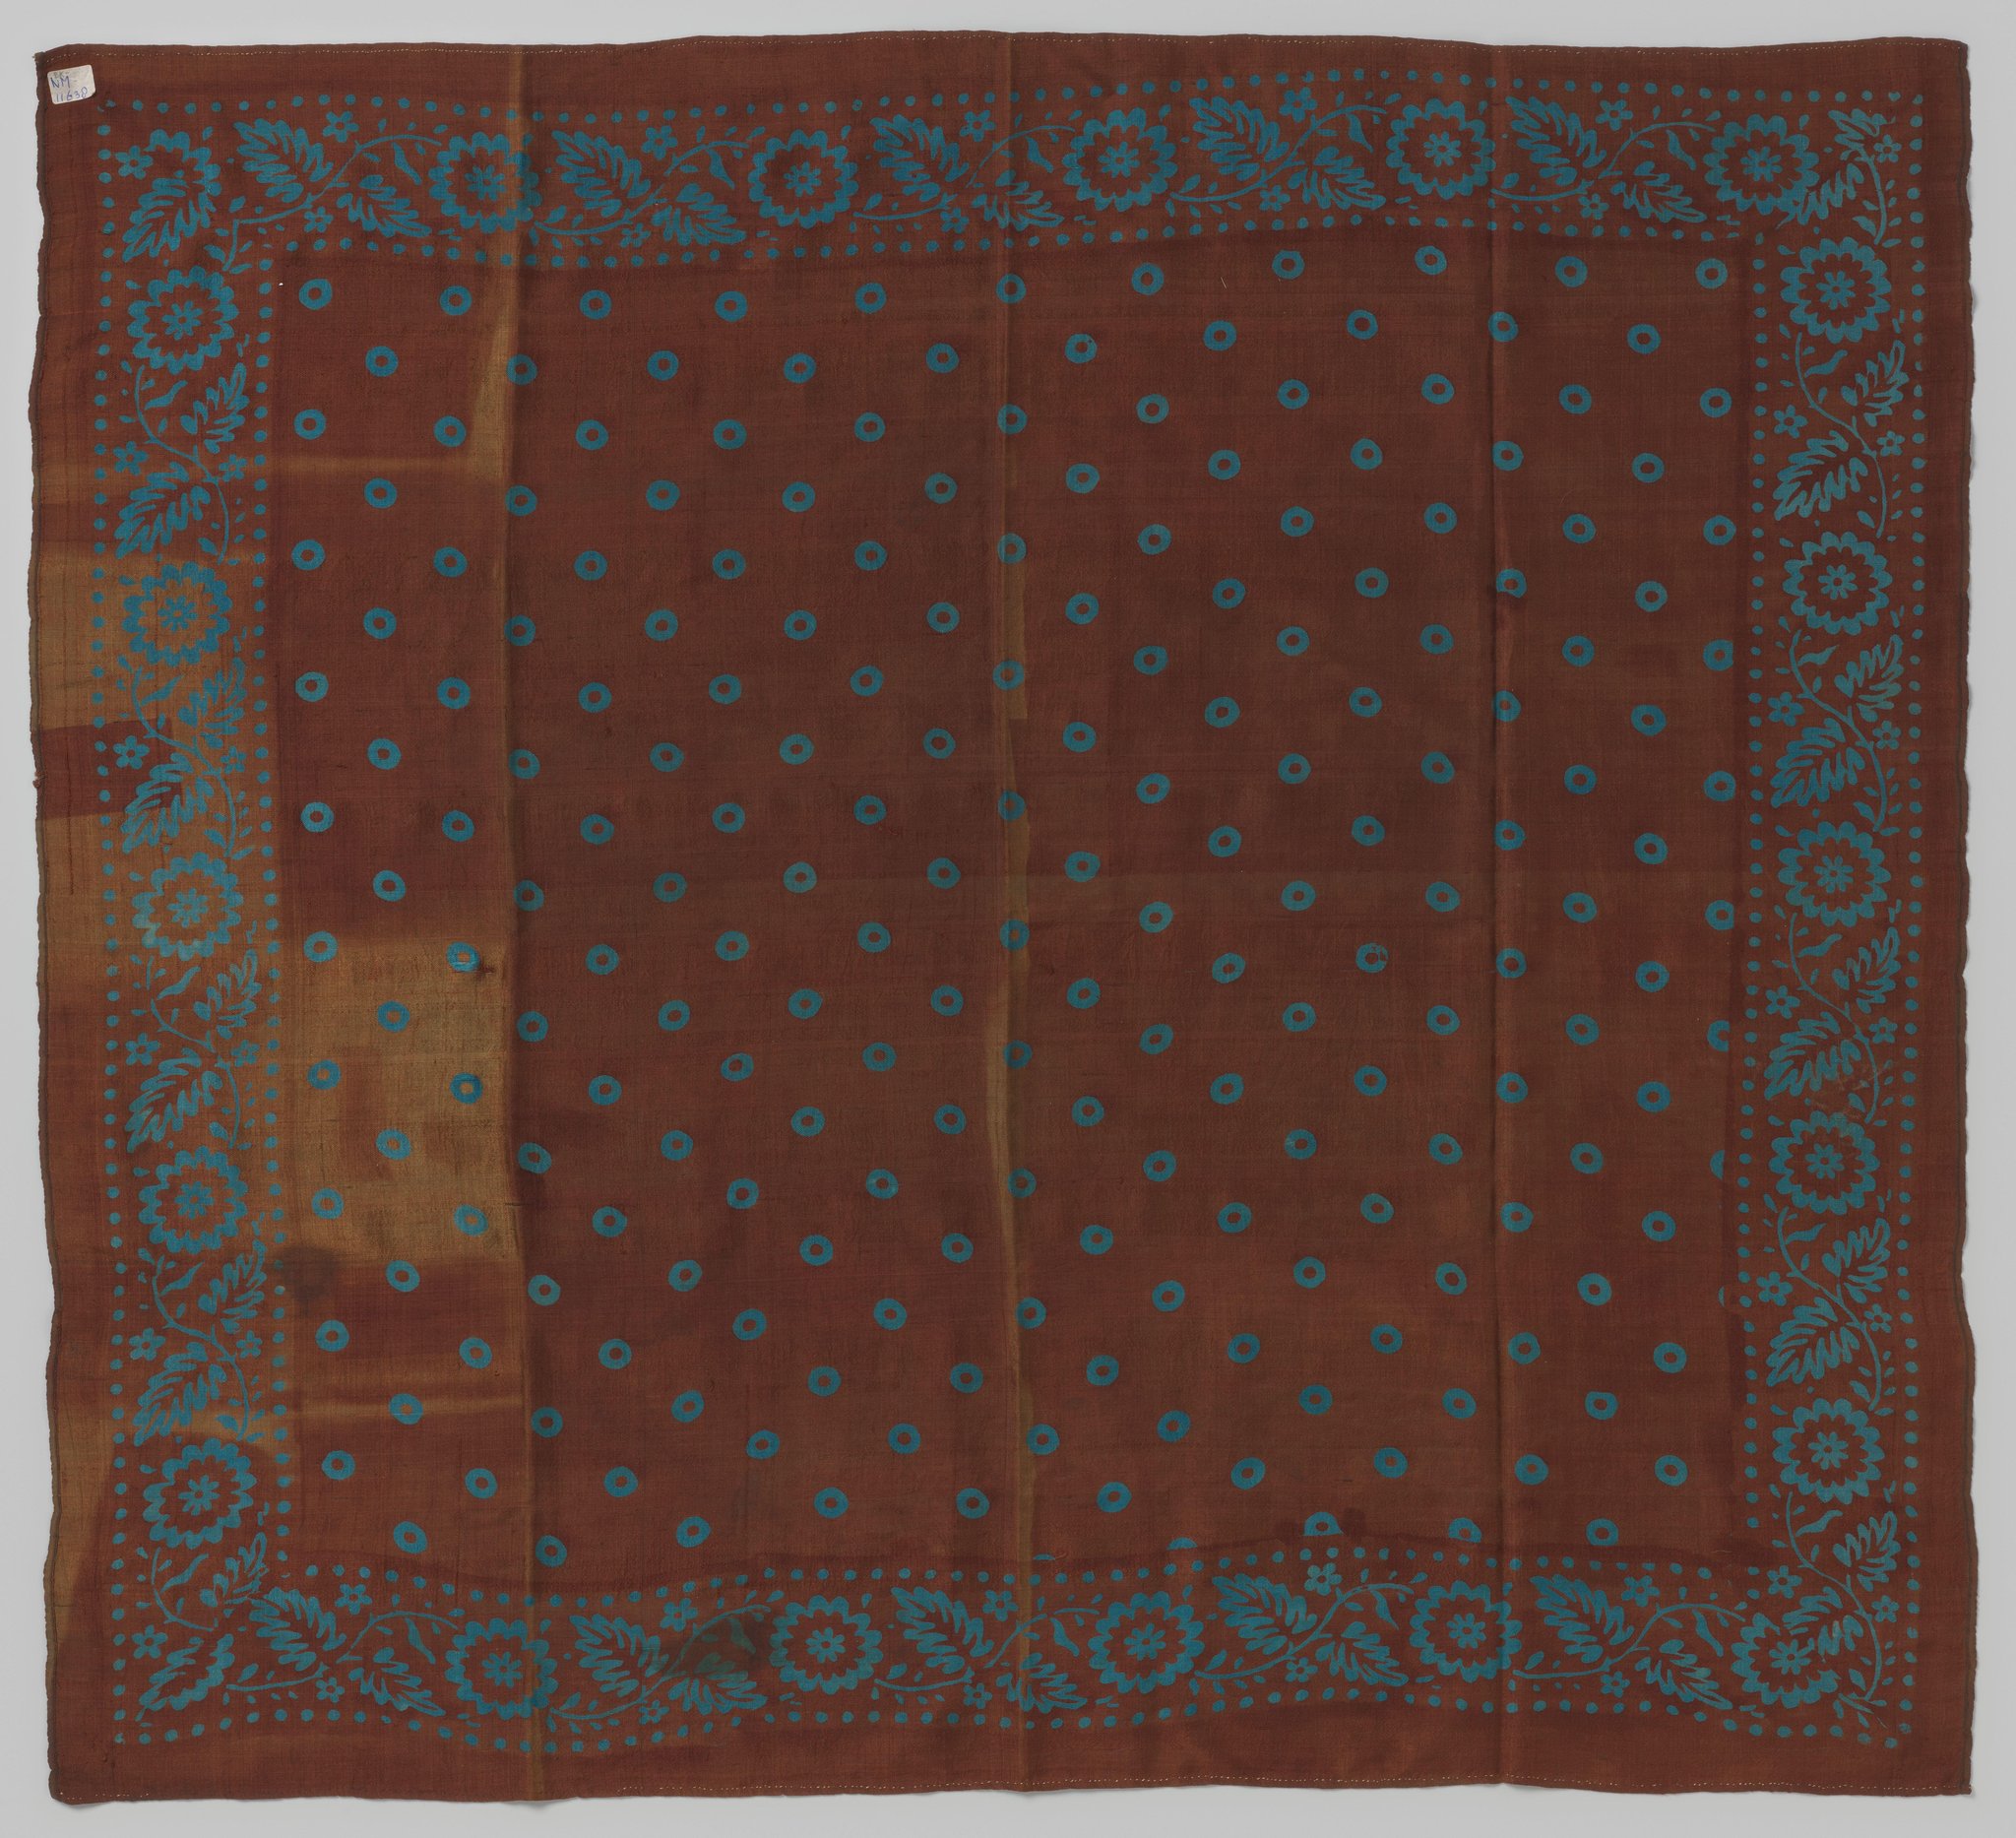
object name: cloth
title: Doek, bruin zijde, omrand met bloemslingers in blauw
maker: Anonymous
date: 1850-1900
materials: silk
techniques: printing block, weave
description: Doek, bruin zijde, omrand met bloemsingers in blauw en geheel versierd me blauwe ringen; over twee zijden gezoomd. Volgens de bijgevoegde gelegaliseerde verklaring afkomstig van de luitenant ter zee Van Speyck.